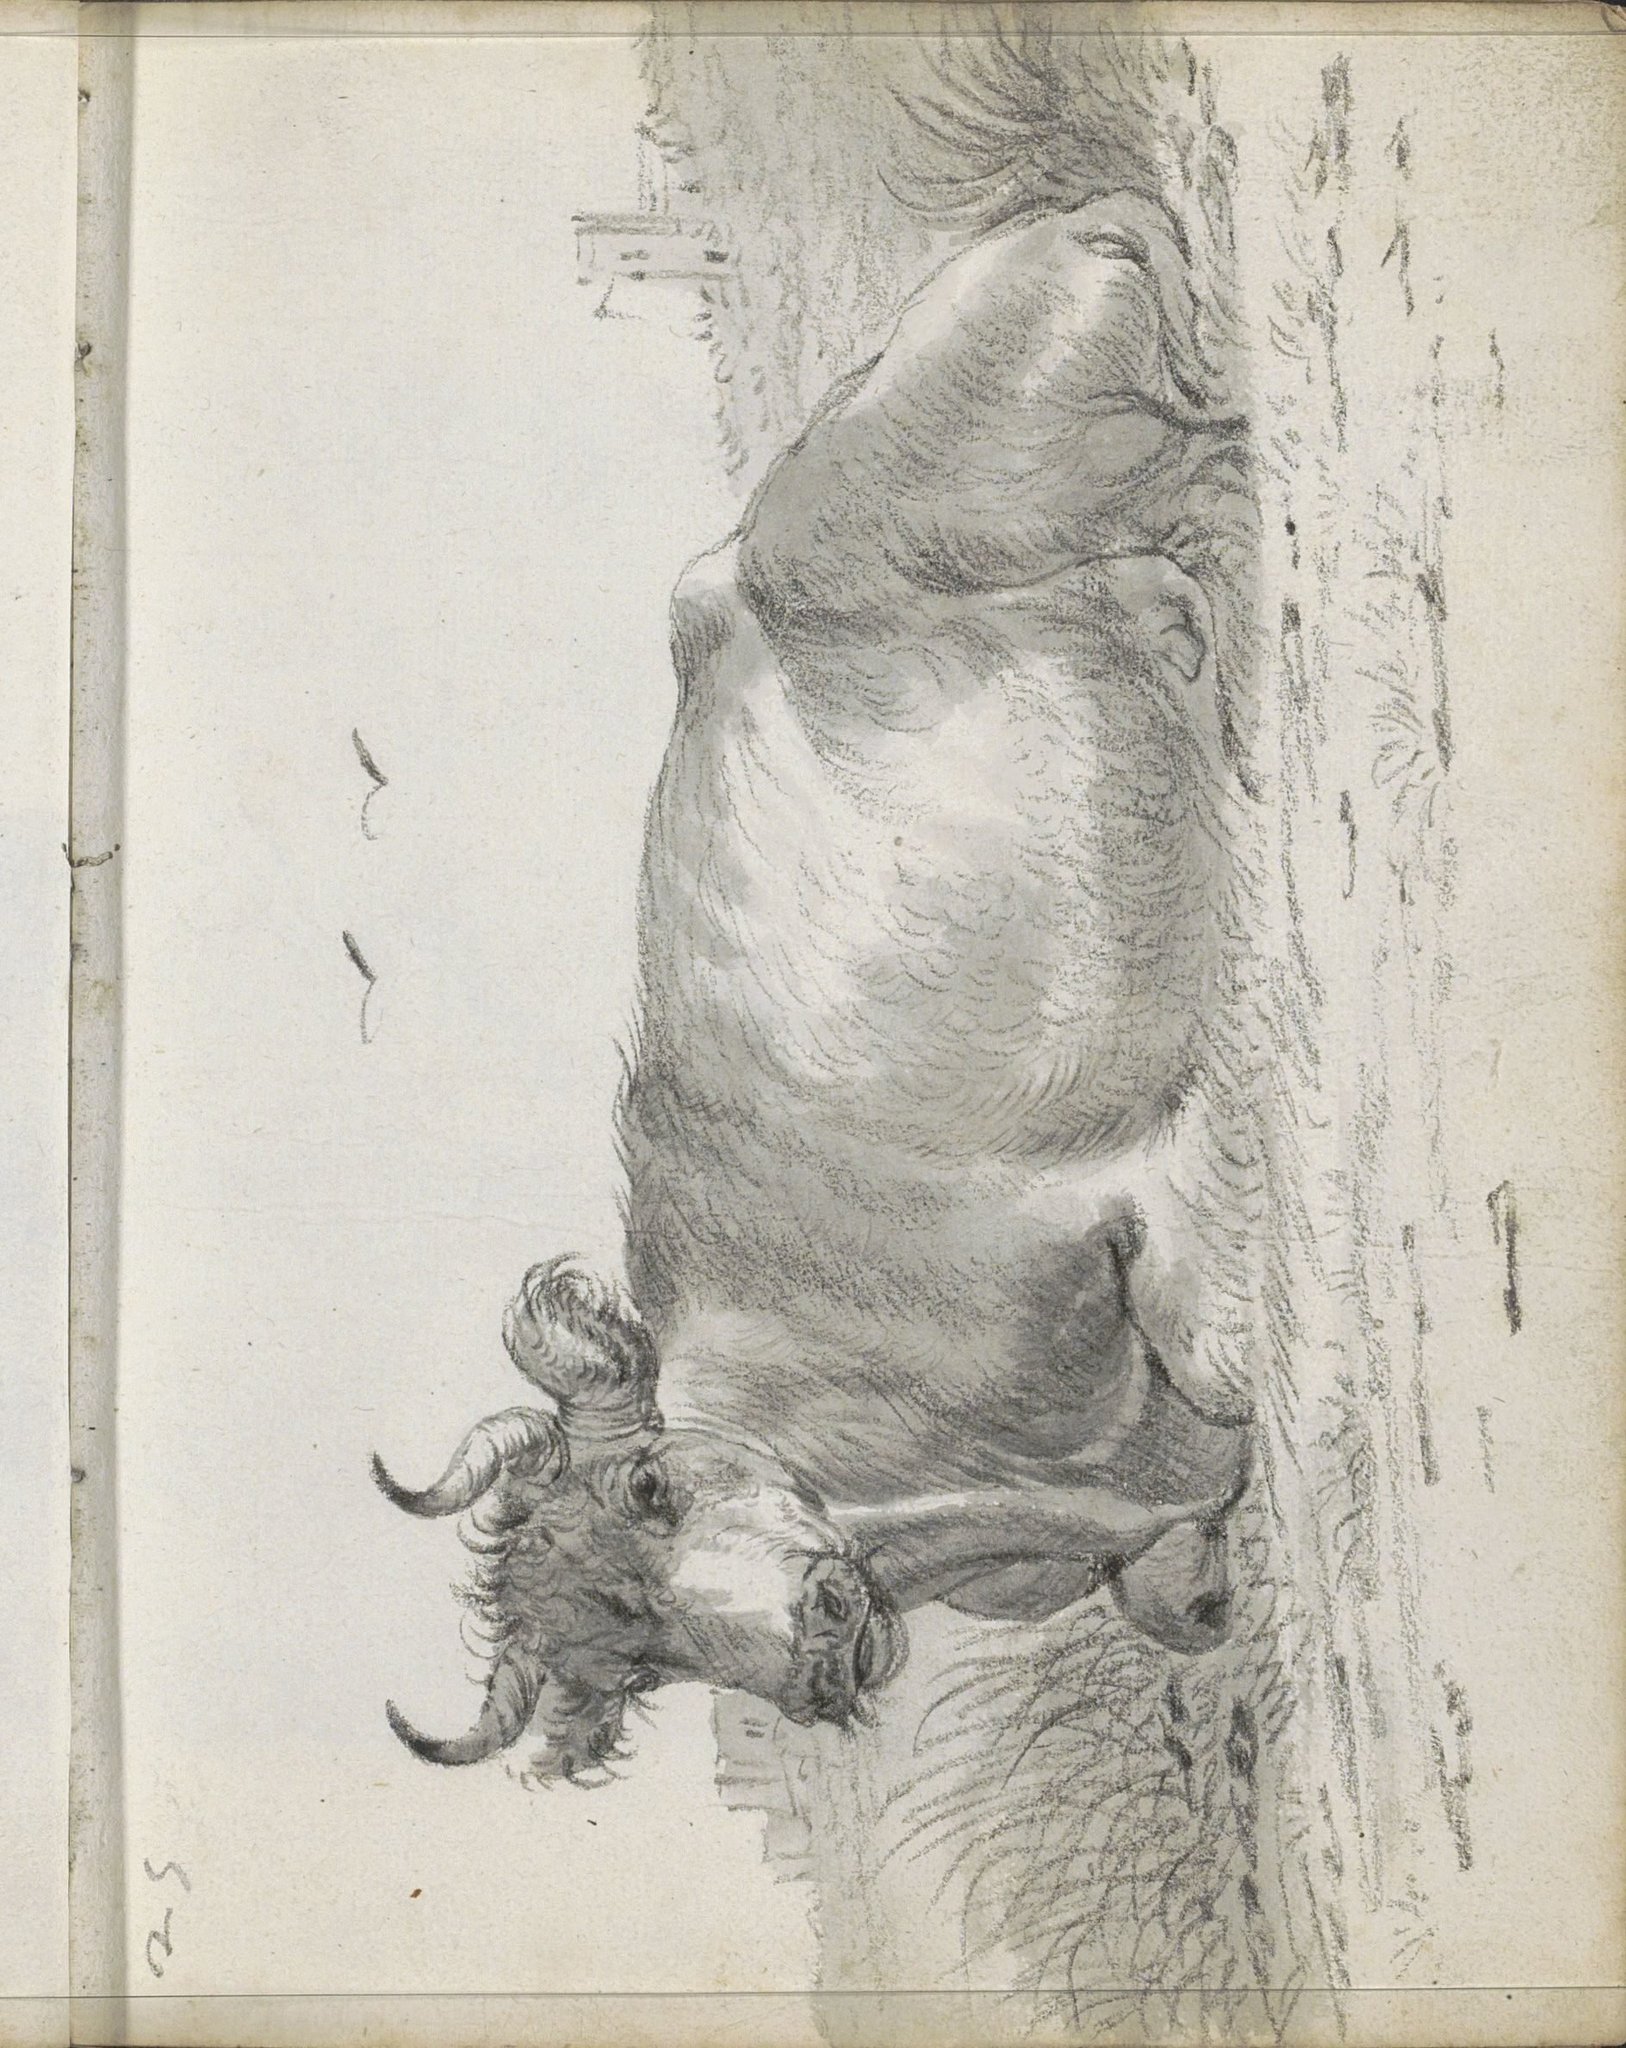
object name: sketchbook leaf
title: Liggende koe in een landschap met bebouwing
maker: cornelis saftleven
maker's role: draughtsman, painter, print maker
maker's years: 1607-1681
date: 1666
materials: chalk, ink, paper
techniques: brush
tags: city-view, and landscape with man-made constructions, cow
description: Blad 25 recto uit een schetsboek met 49 bladen.